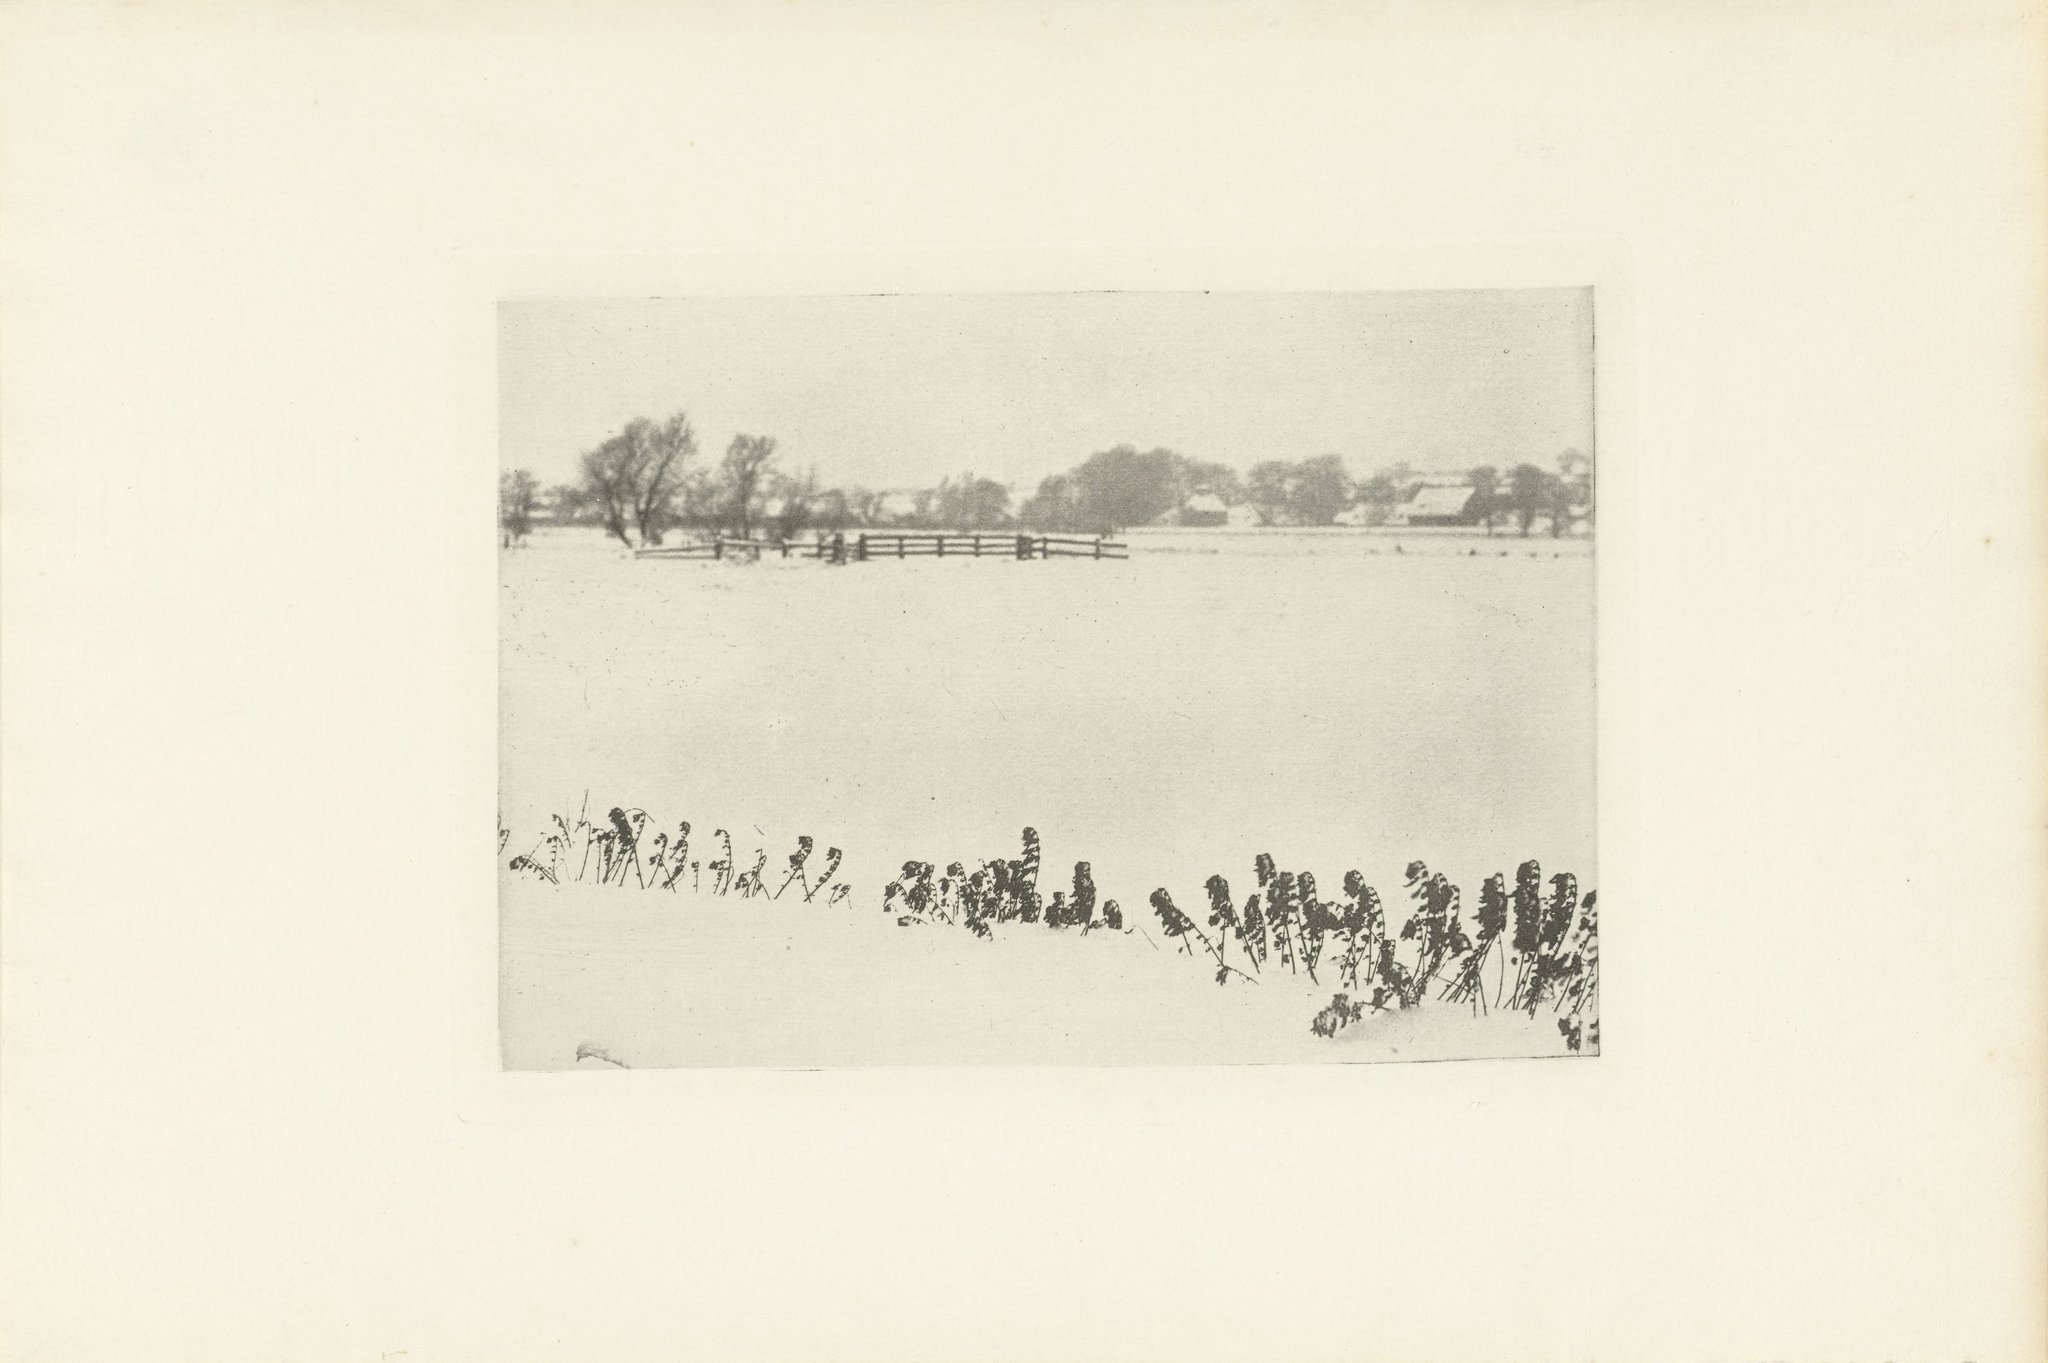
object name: photomechanical print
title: March snow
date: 1883-1893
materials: paper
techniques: photoaquatint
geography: great britain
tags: snow, great britain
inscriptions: watermark: ‘John Dickinson & Co.’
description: Originele titel is afgeleid uit literatuur.